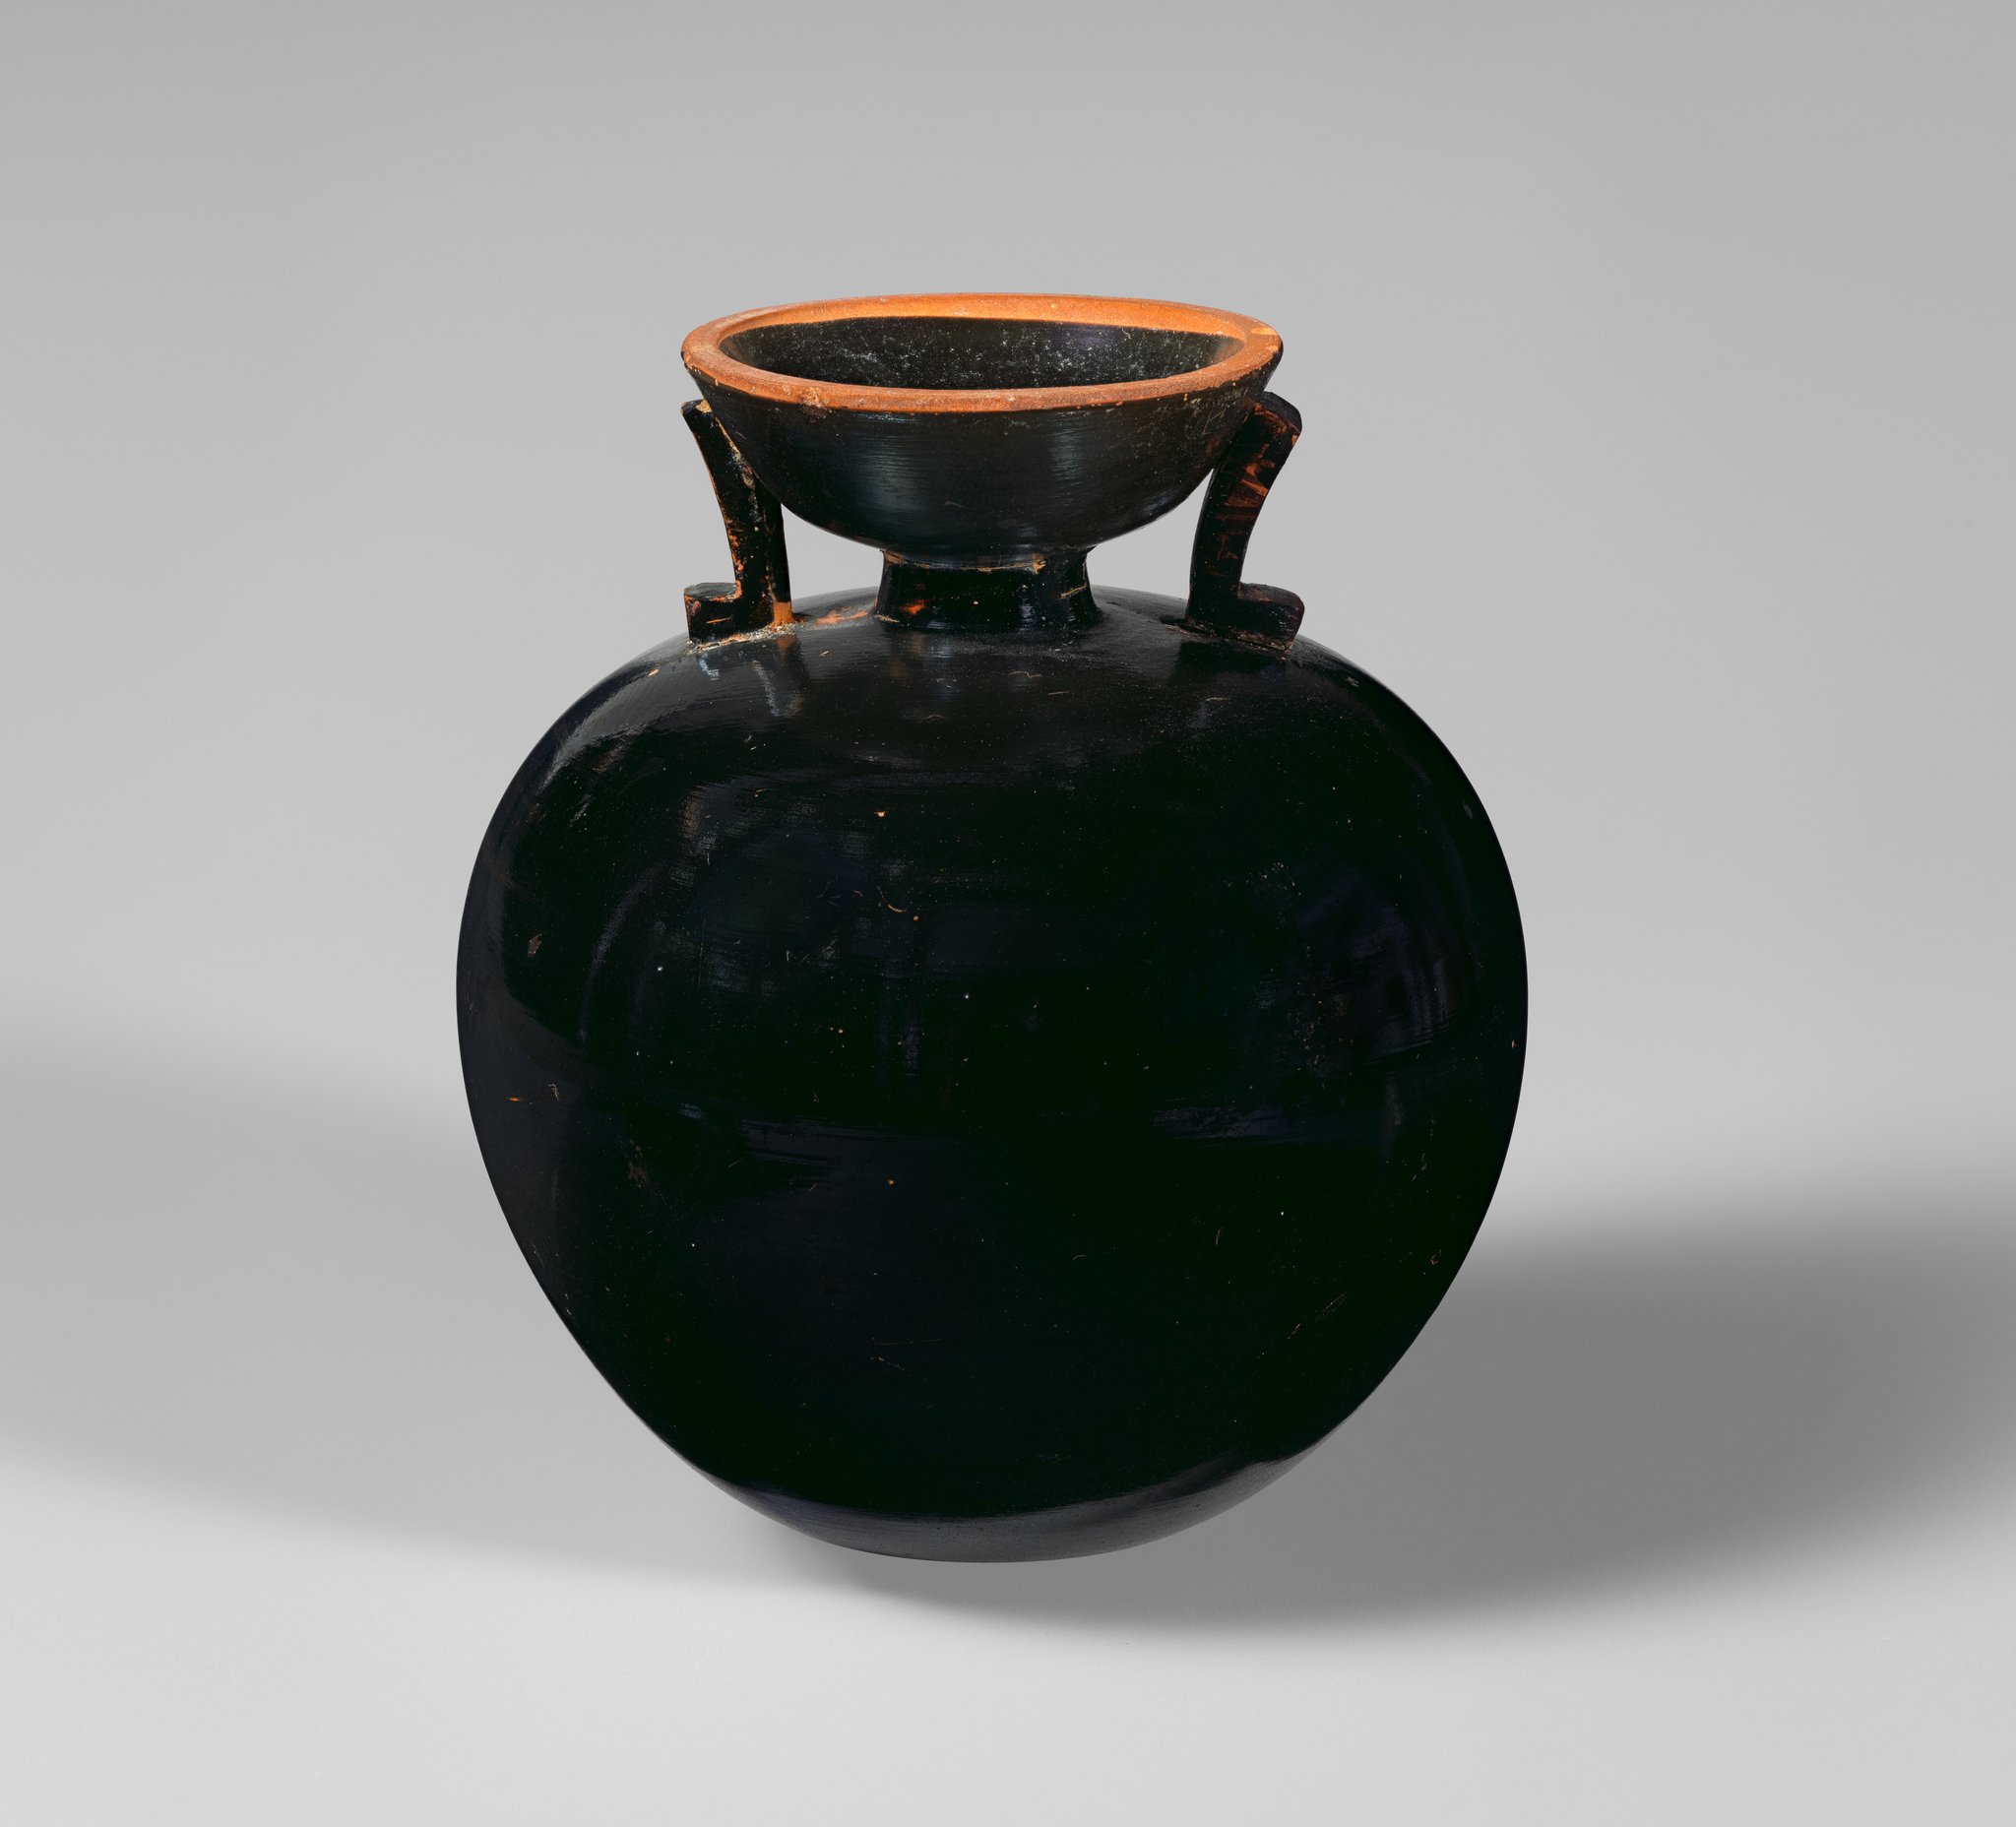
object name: aryballos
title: Terracotta aryballos (oil flask)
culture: greek, attic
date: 510 BCE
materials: terracotta